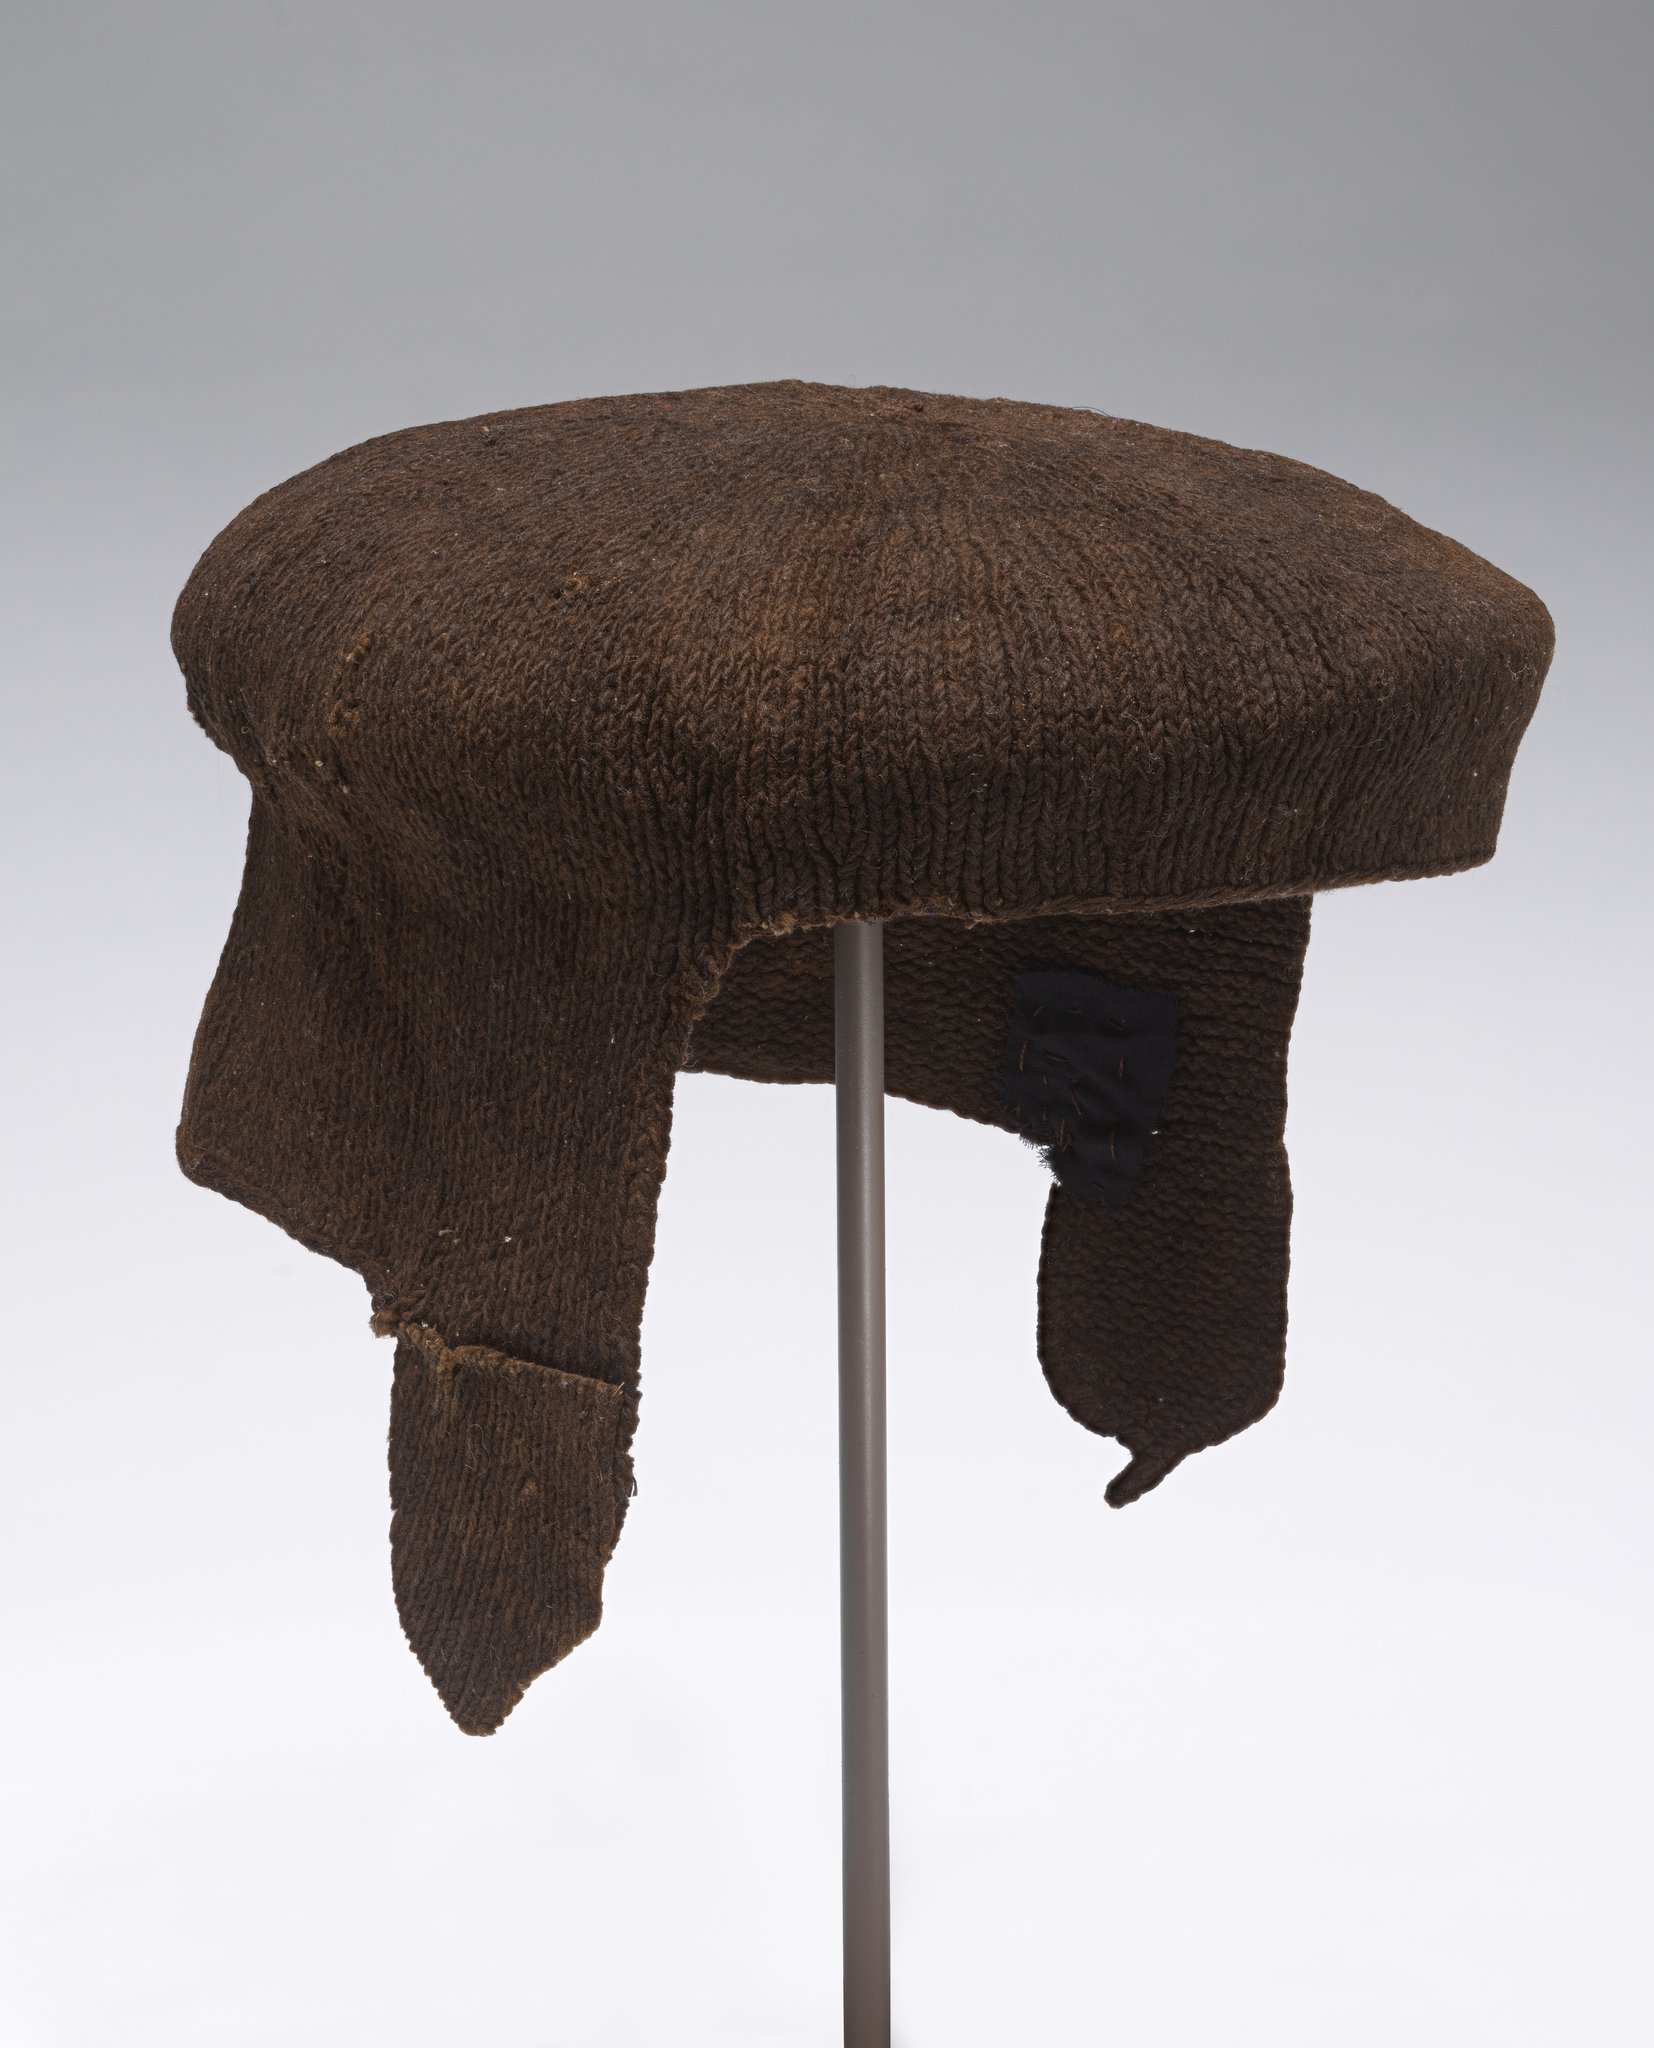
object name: cap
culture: british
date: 1501-1600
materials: wool